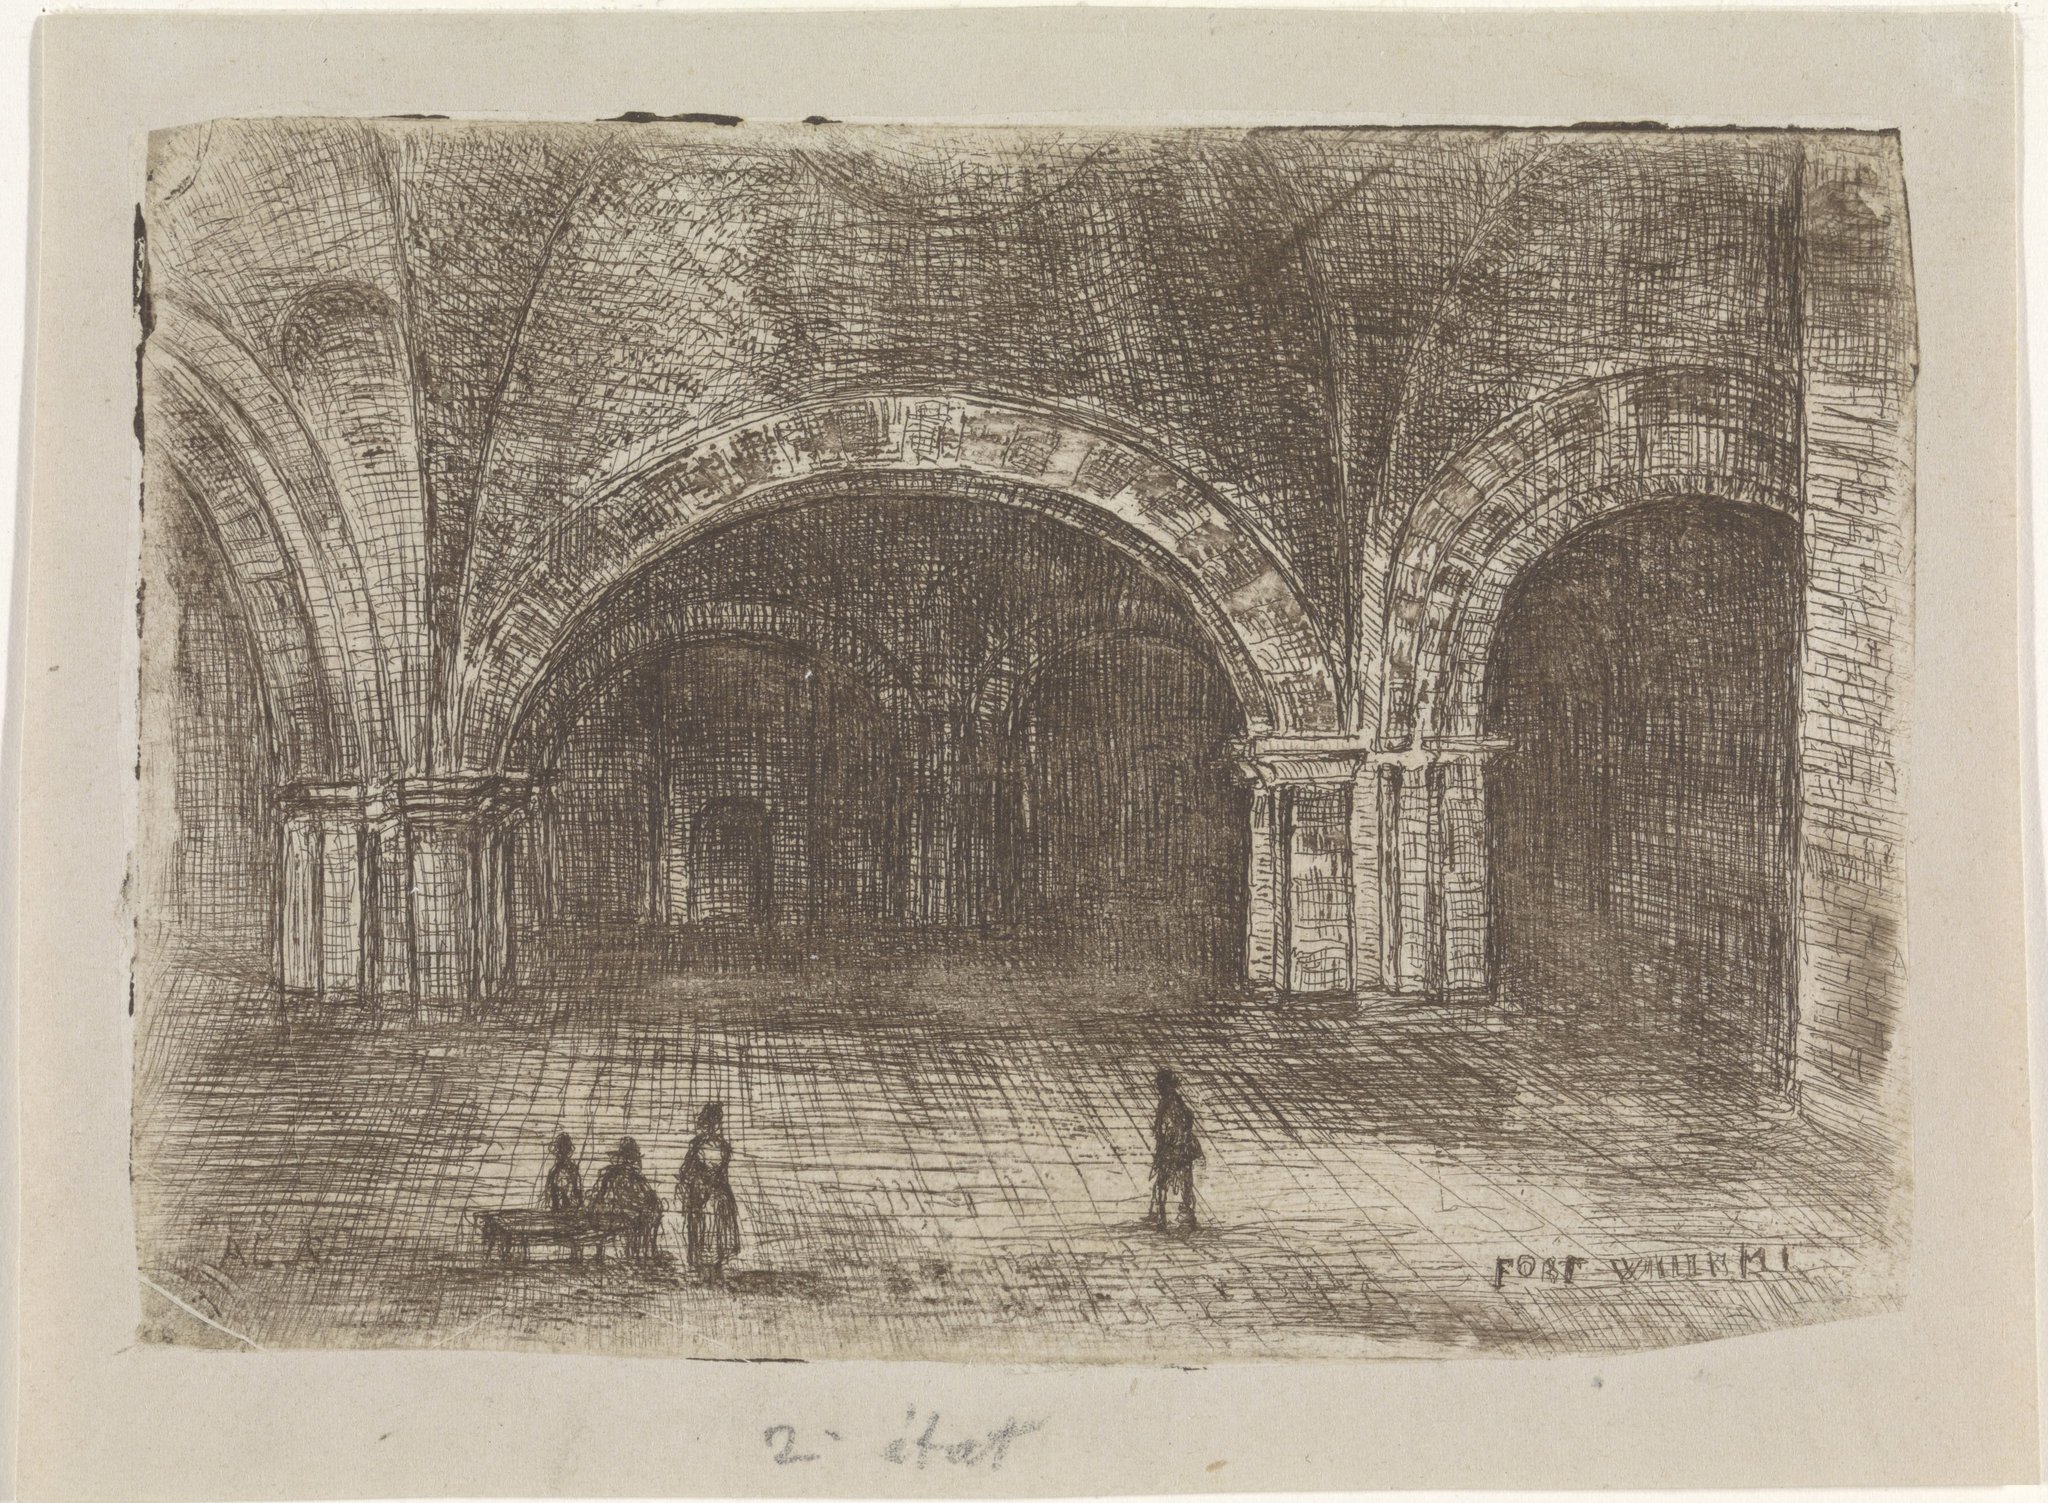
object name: print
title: Fort Willem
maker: alexander schaepkens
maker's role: draughtsman, print maker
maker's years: 1815-1899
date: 1830-1899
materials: paper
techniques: etching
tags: fortress, maastricht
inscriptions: collector's mark: Lugt 2228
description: Fort Koning Willem I te Maastricht, gebouwd in 1815-1818.